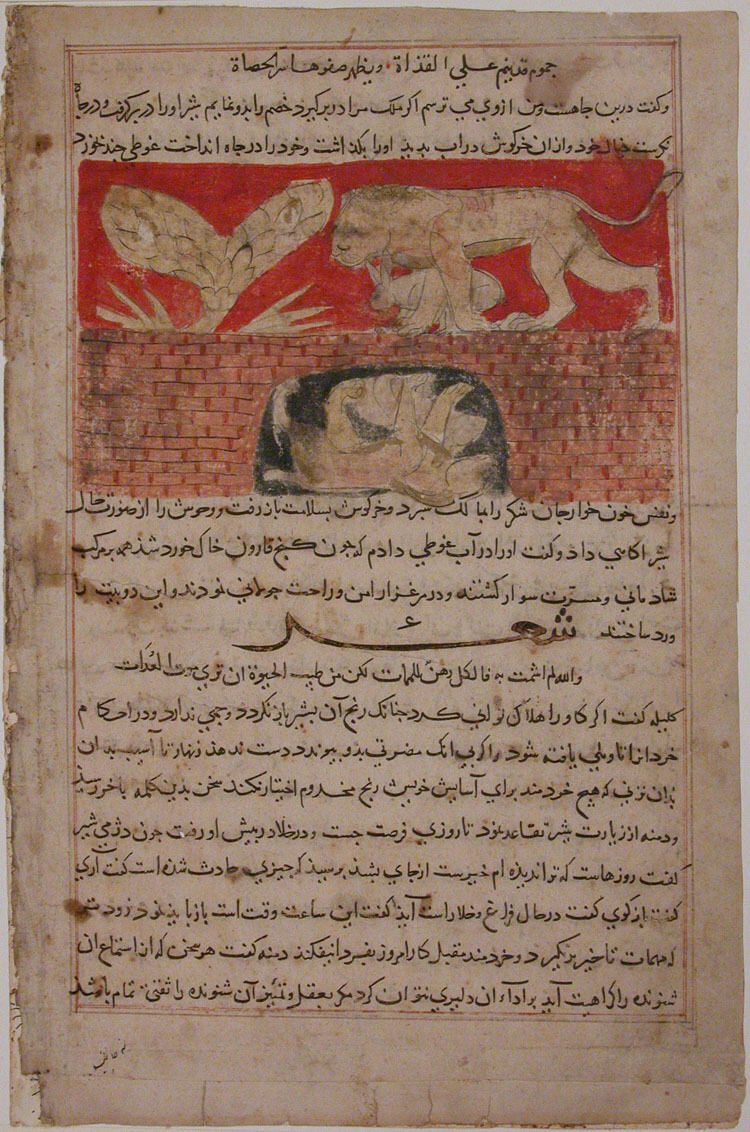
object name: folio from an illustrated manuscript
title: "Fable of the Lion and the Hare", Folio from a Kalila wa Dimna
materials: gold, paper, watercolor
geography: iran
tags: lions,rabbits